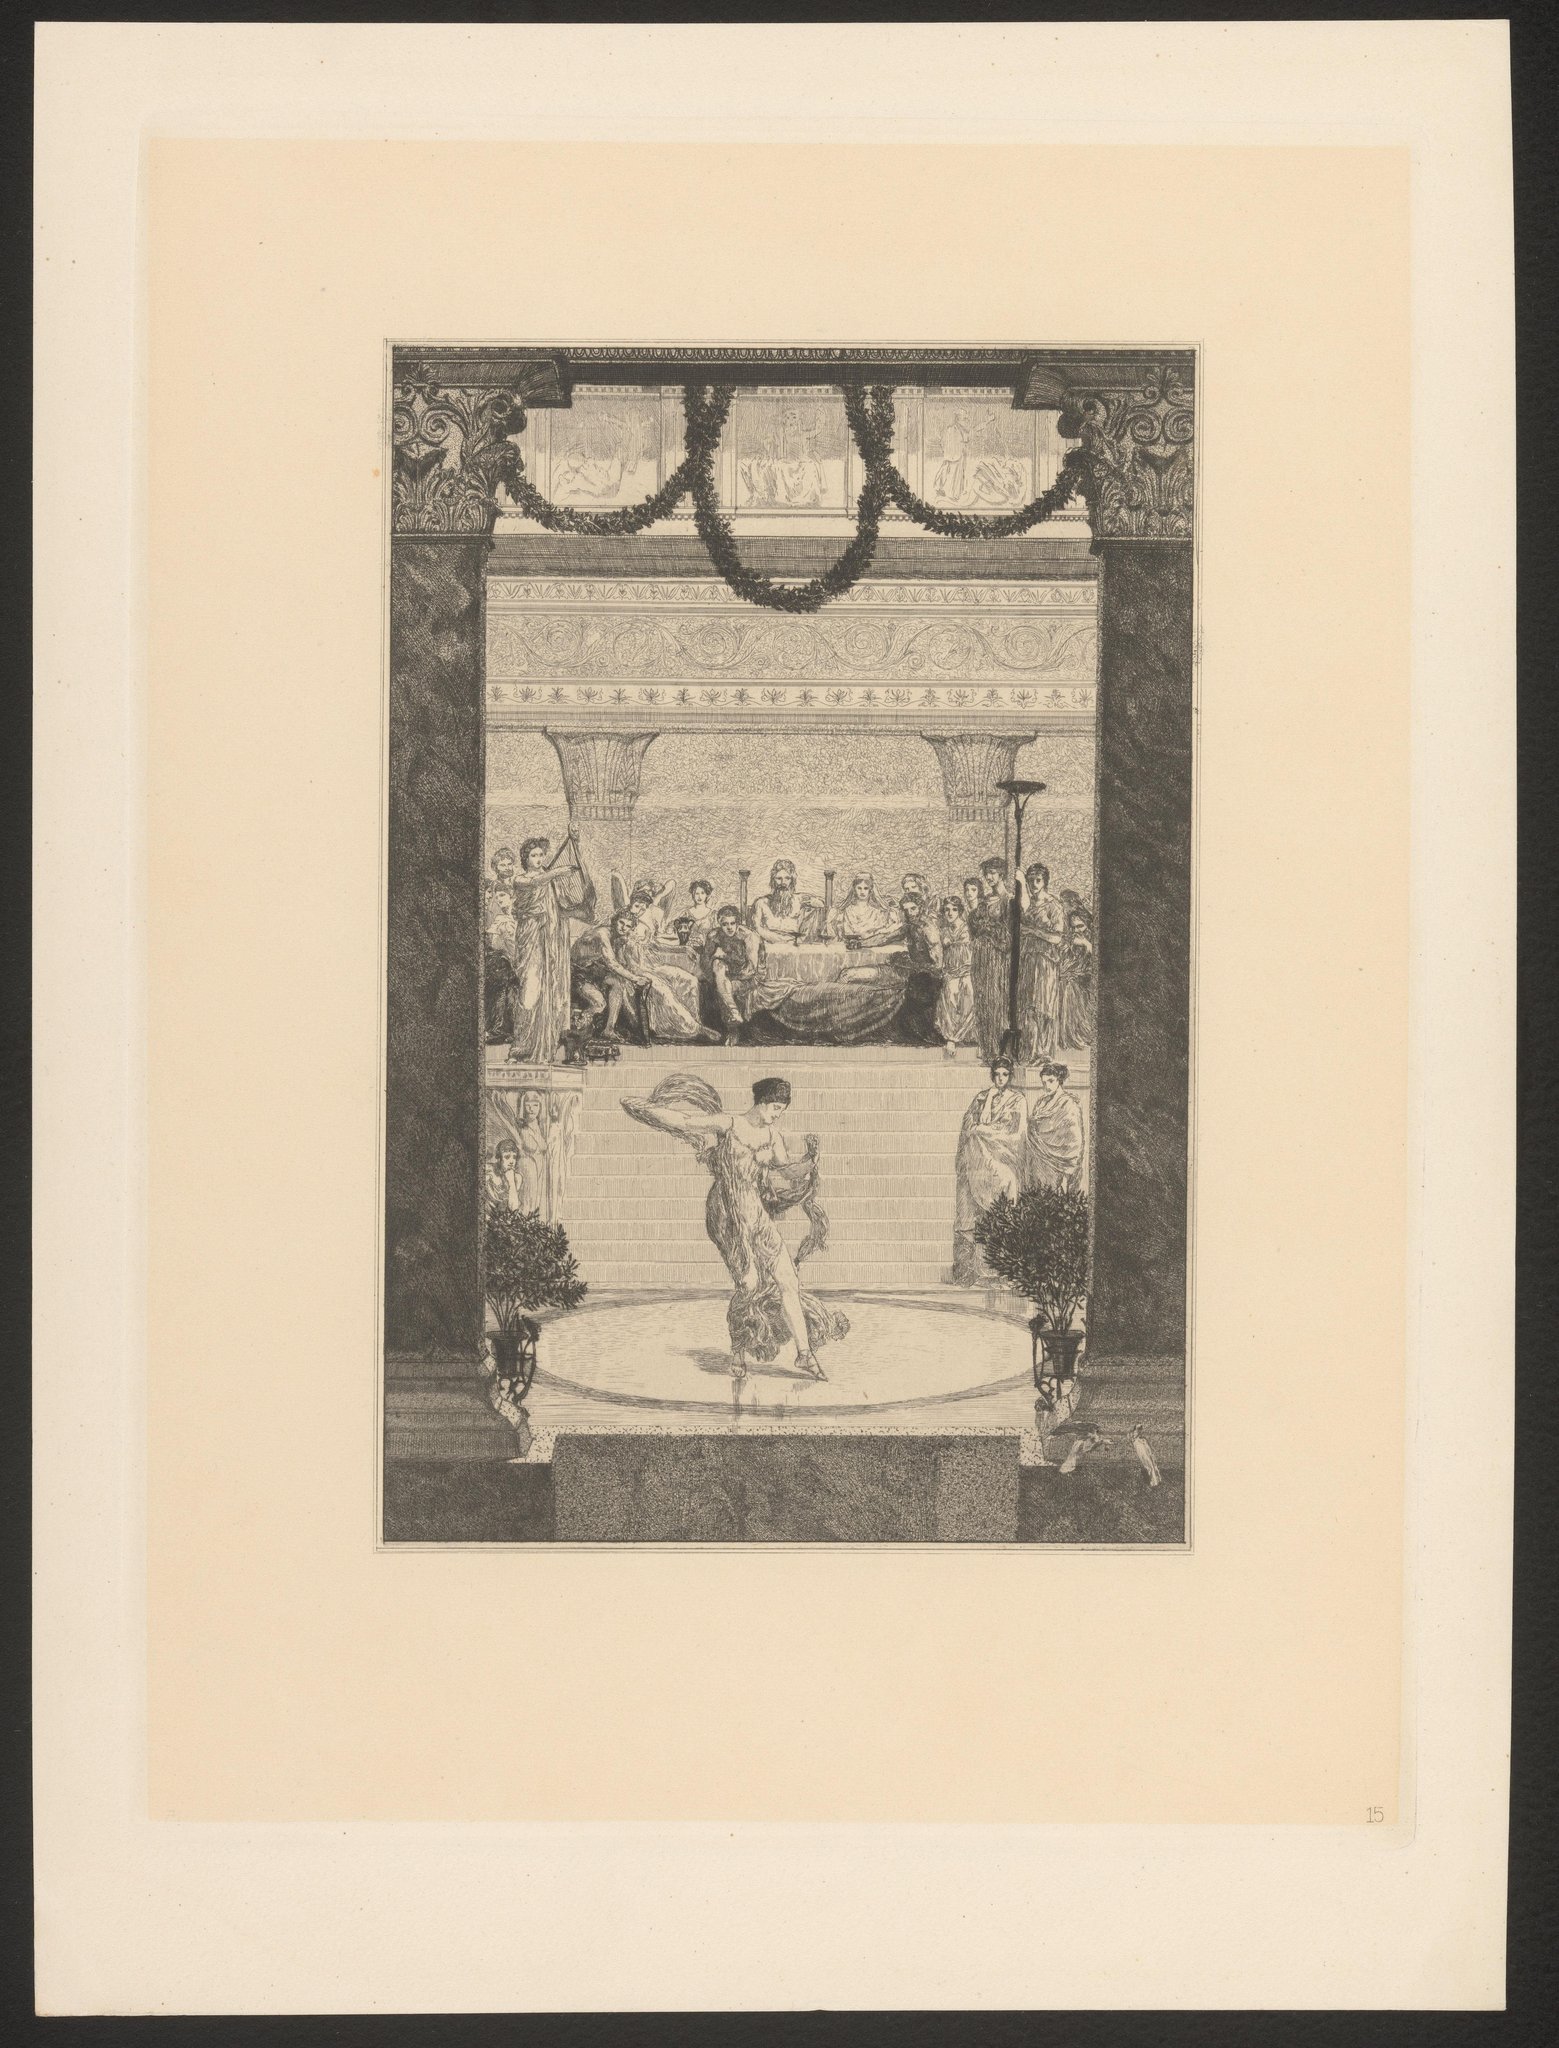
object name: print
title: Etsen bij Amor en Psyche van Apuleius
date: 1880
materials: paper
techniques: aquatint, etching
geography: nuremberg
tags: (civil) marriage ceremonies, other scenes from the story of cupid and psyche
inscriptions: collector's mark: Lugt 2228